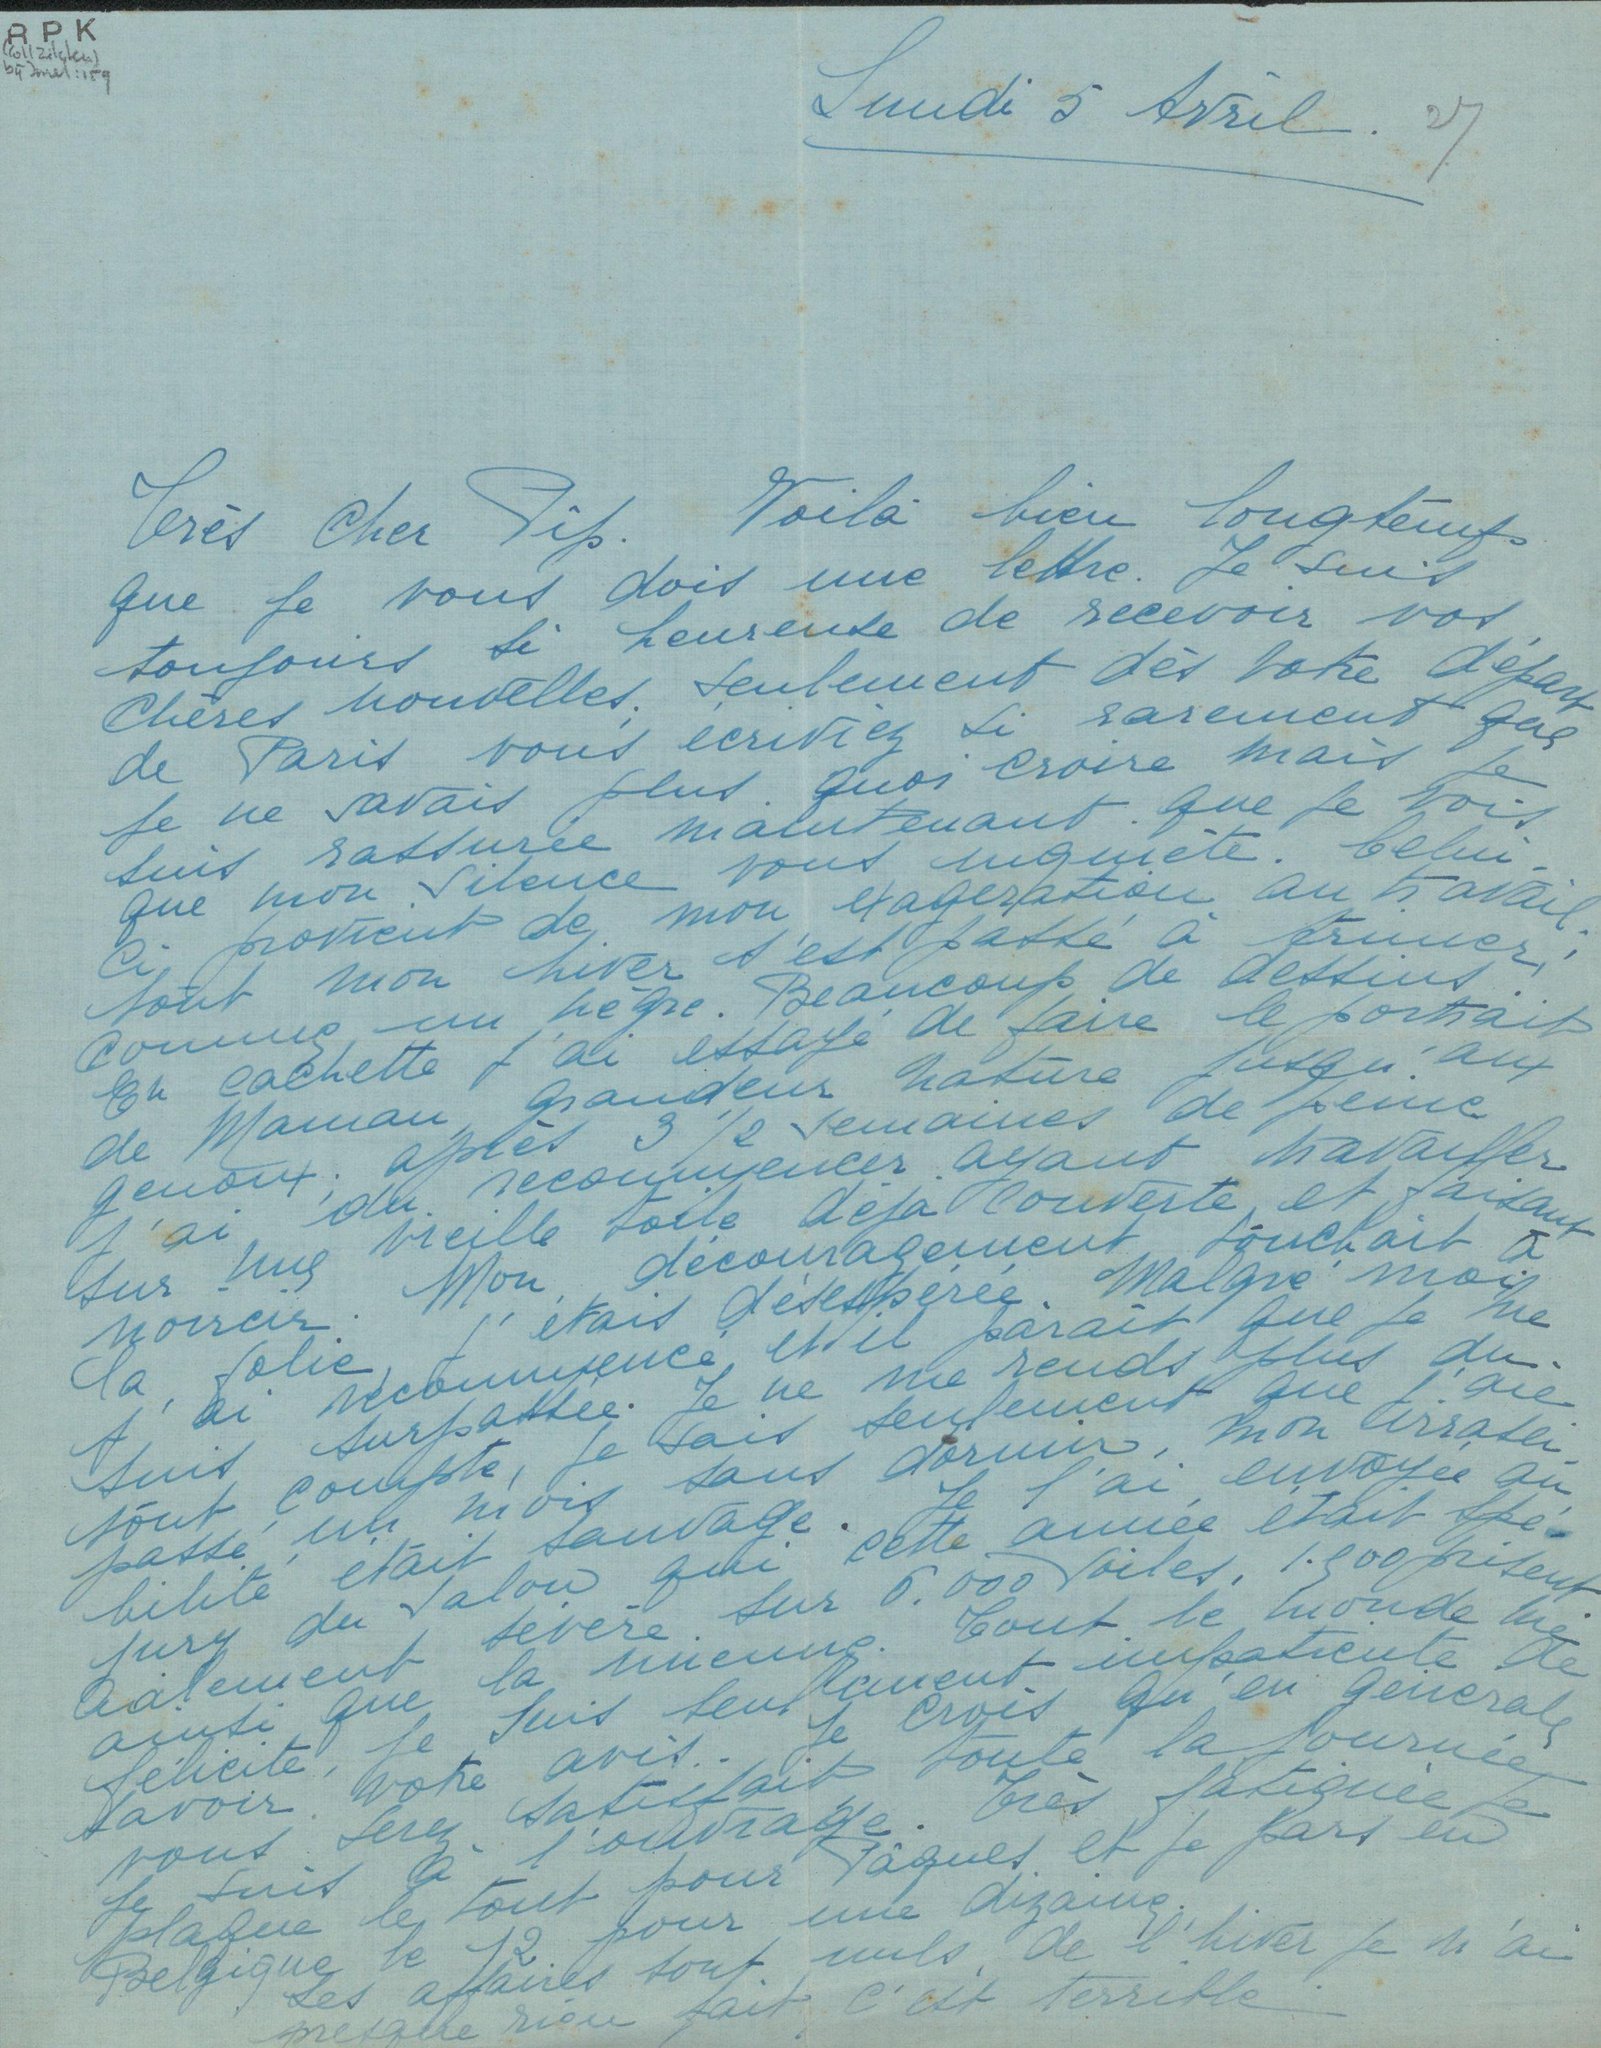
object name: letter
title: Brief aan Philip Zilcken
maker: rose imel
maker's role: draughtsman, painter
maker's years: 1901-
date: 1911-1930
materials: cardboard, ink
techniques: pen, writing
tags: the hague, painter, draughtsman, philip zilcken, drawing, painting (including book-illumination, miniature-painting), exhibition ~ art, historical persons (portraits and scenes from the life), paris, belgium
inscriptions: collector's mark: ‘RPK’